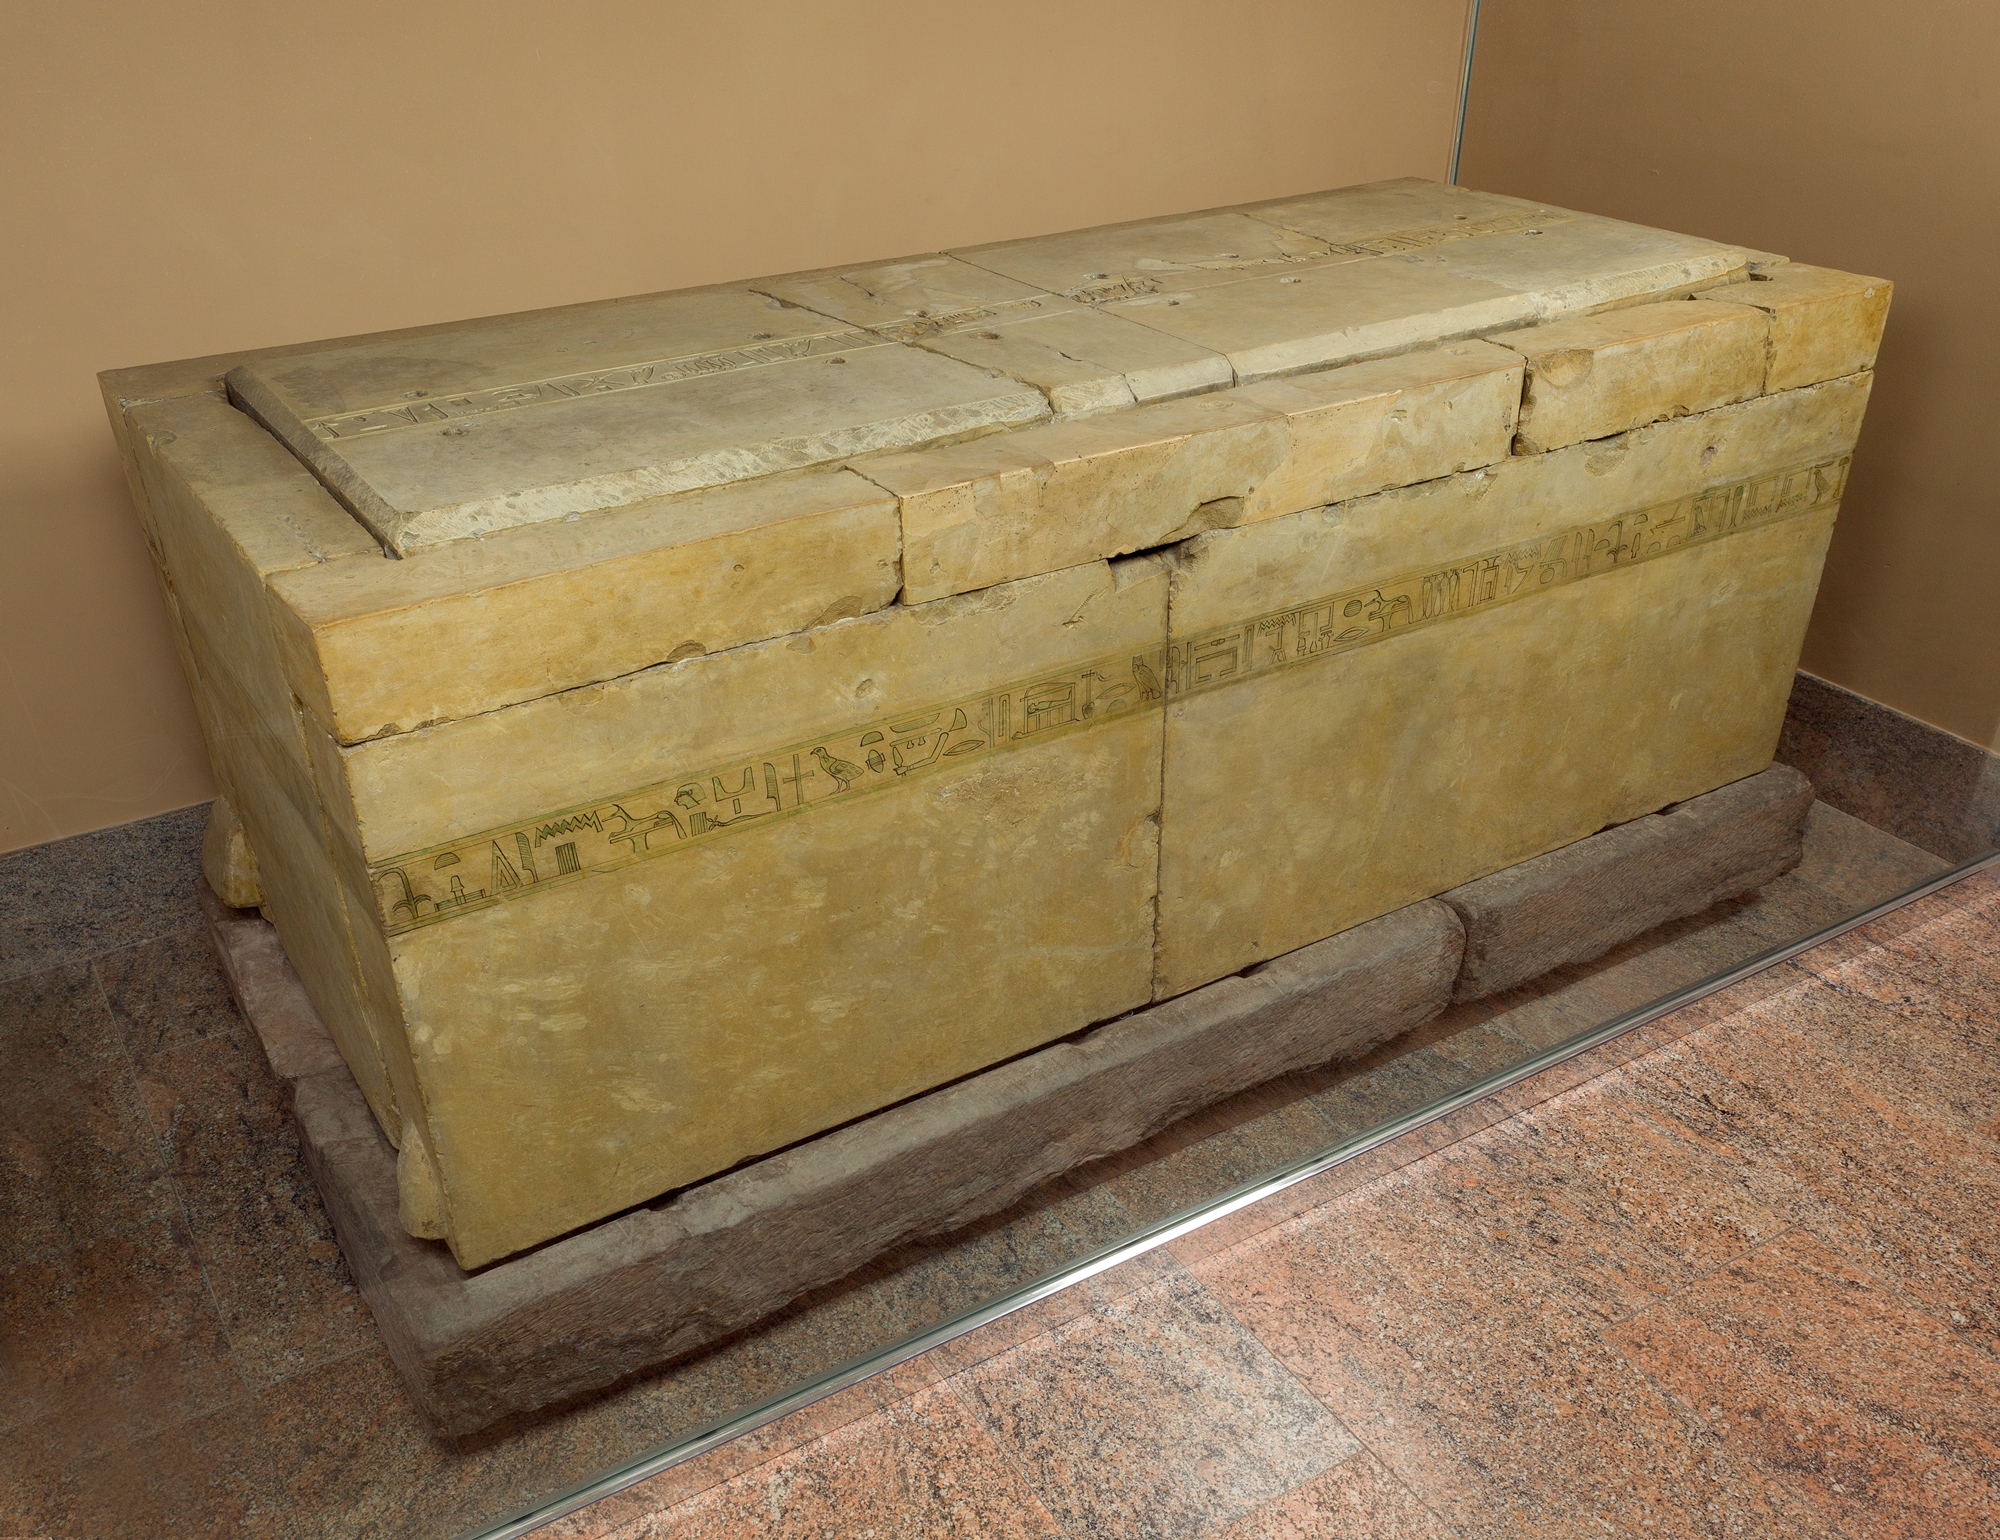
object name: sarcophagus, henhenet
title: Sarcophagus of the Hathor Priestess Henhenet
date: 2051-2030 BCE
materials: limestone, paint, stone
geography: egypt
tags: hieroglyphs,sarcophagus